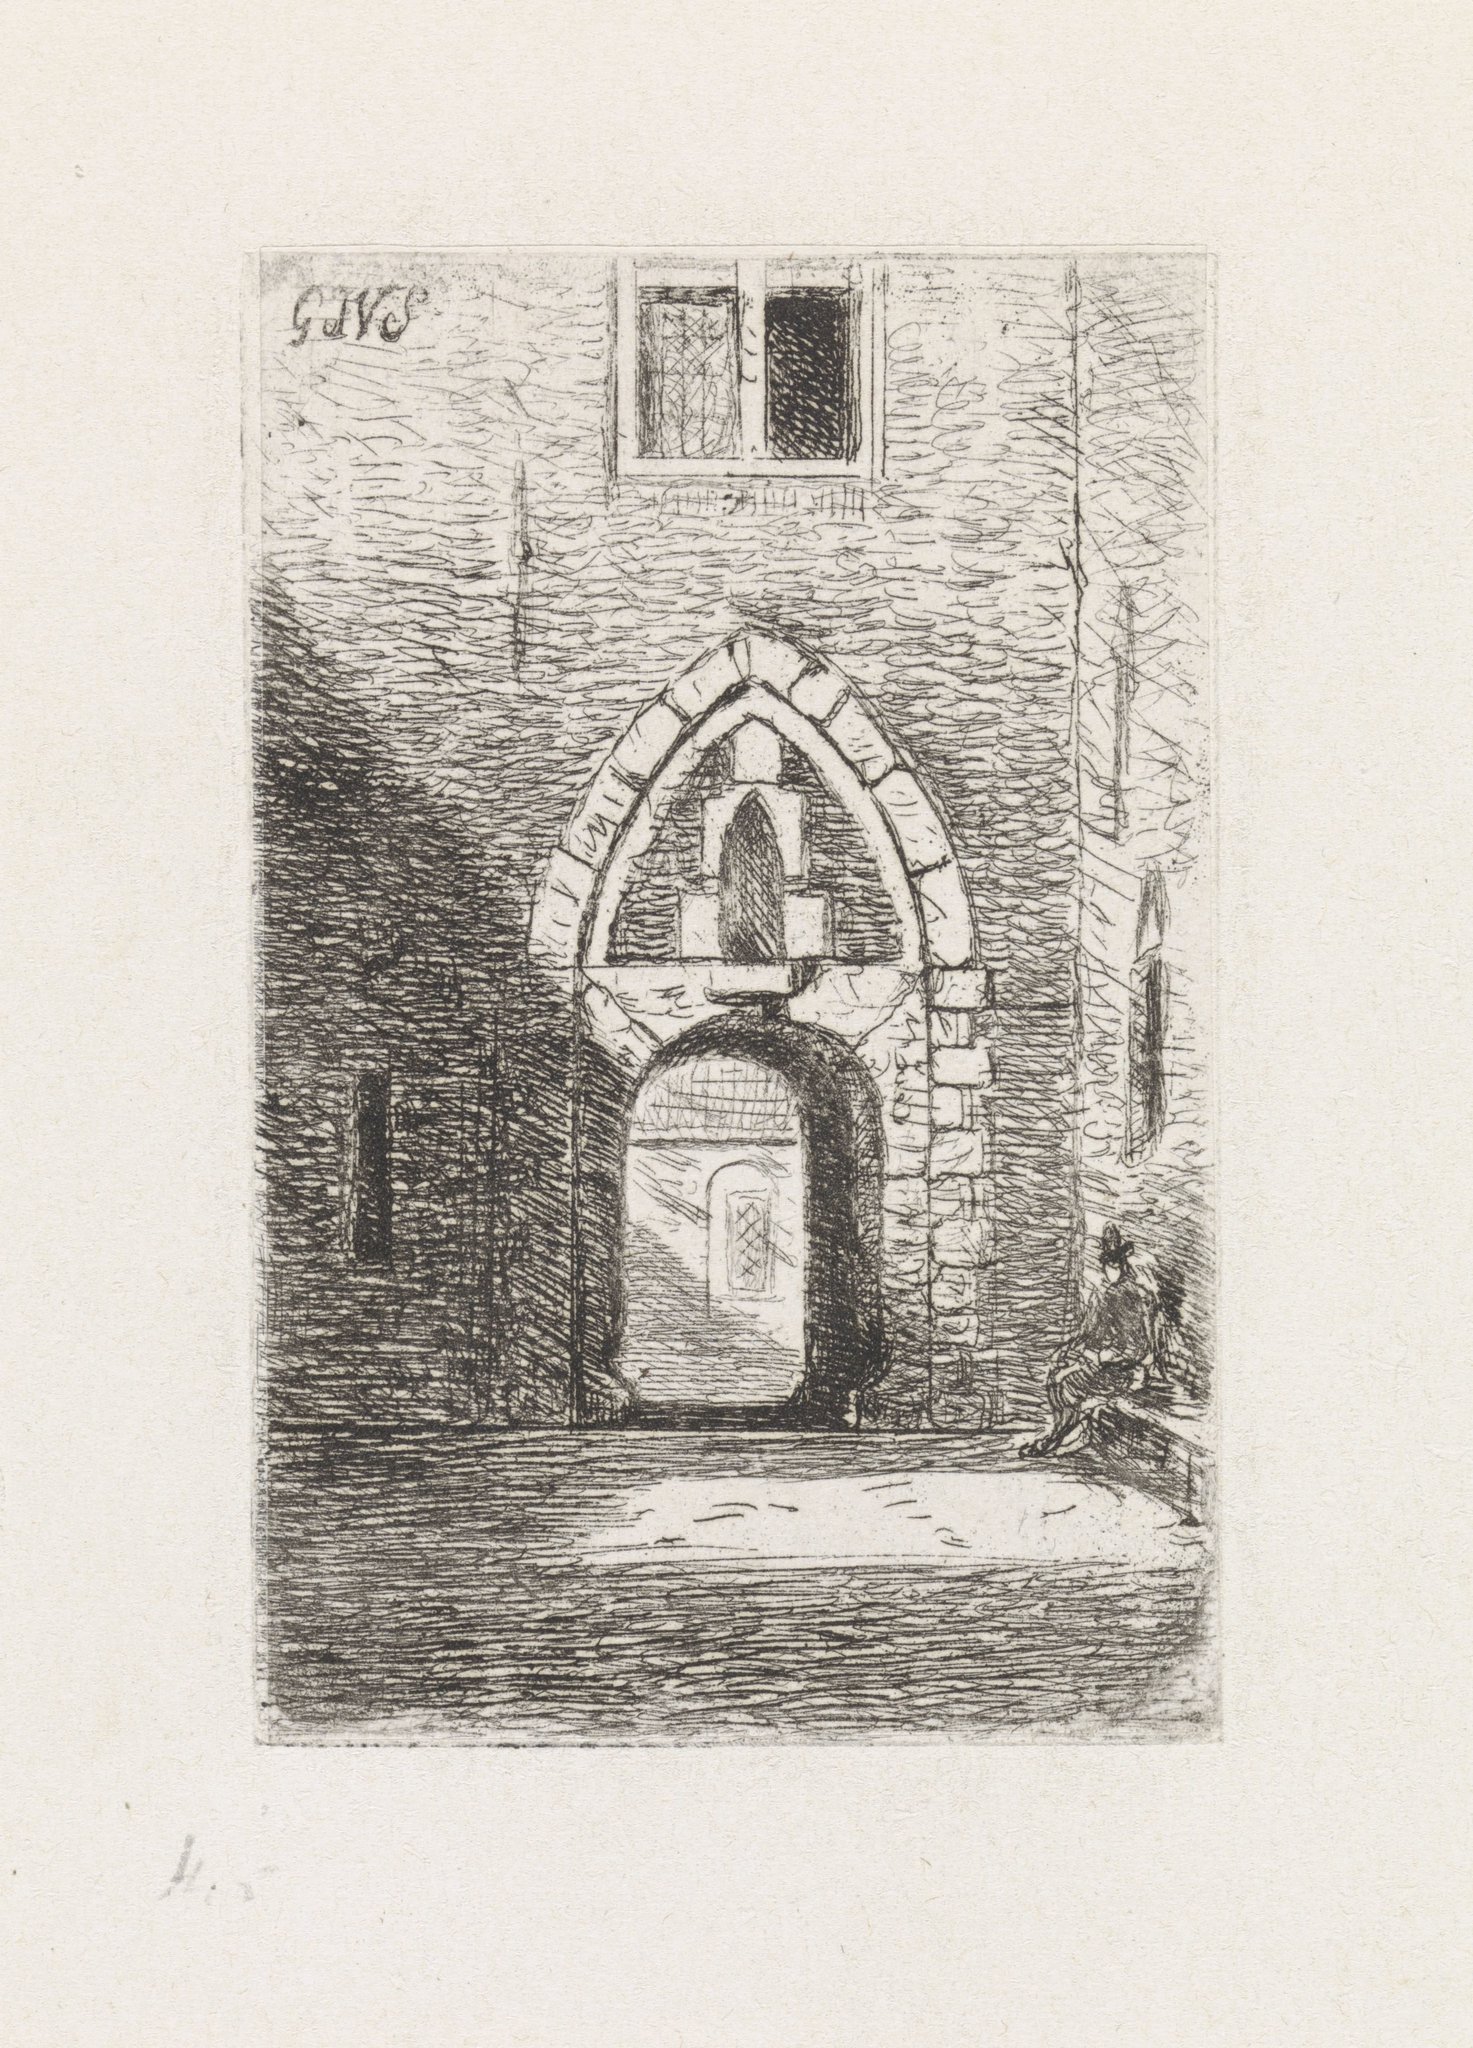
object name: print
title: Gezicht op een poort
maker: gijsbertus johannes verspuy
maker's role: print maker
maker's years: 1823-1862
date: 1833-1862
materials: paper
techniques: etching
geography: netherlands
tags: gate, entrance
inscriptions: collector's mark: Lugt 2228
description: Gezicht op een poort. Links een zittende figuur op een bank.